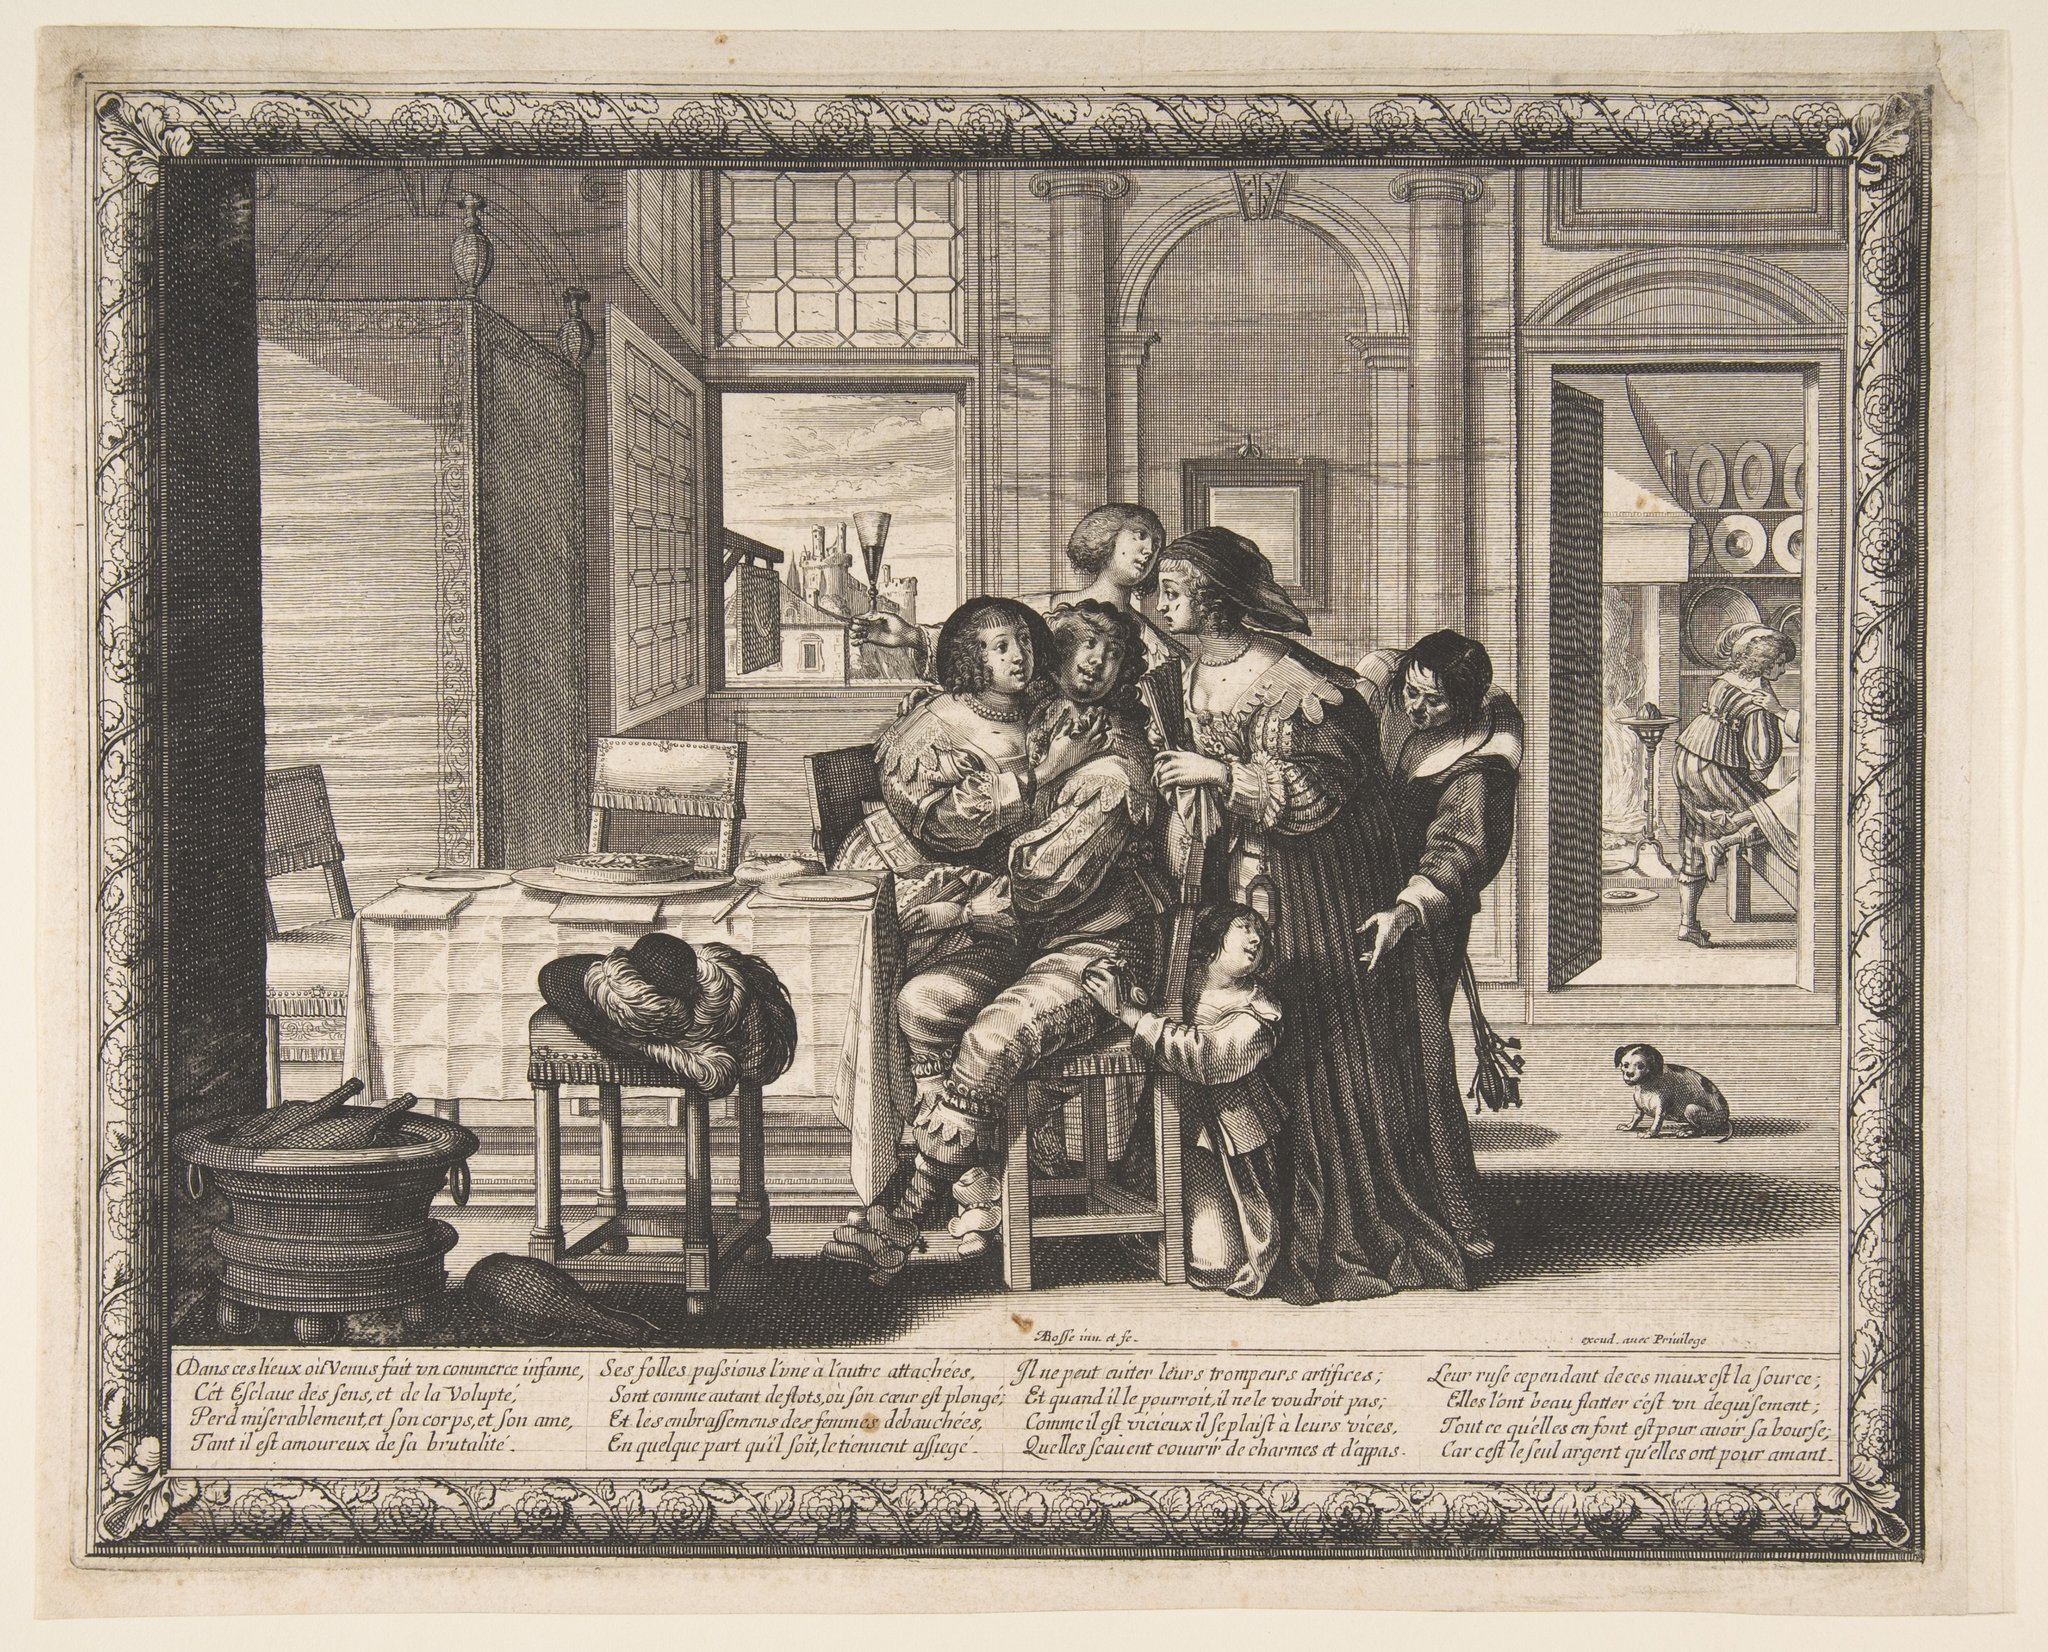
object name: print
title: The Prodigal Son in a House of Ill Repute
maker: abraham bosse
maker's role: artist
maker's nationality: french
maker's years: 1602-1676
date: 1636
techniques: etching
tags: interiors,children,men,women,dogs